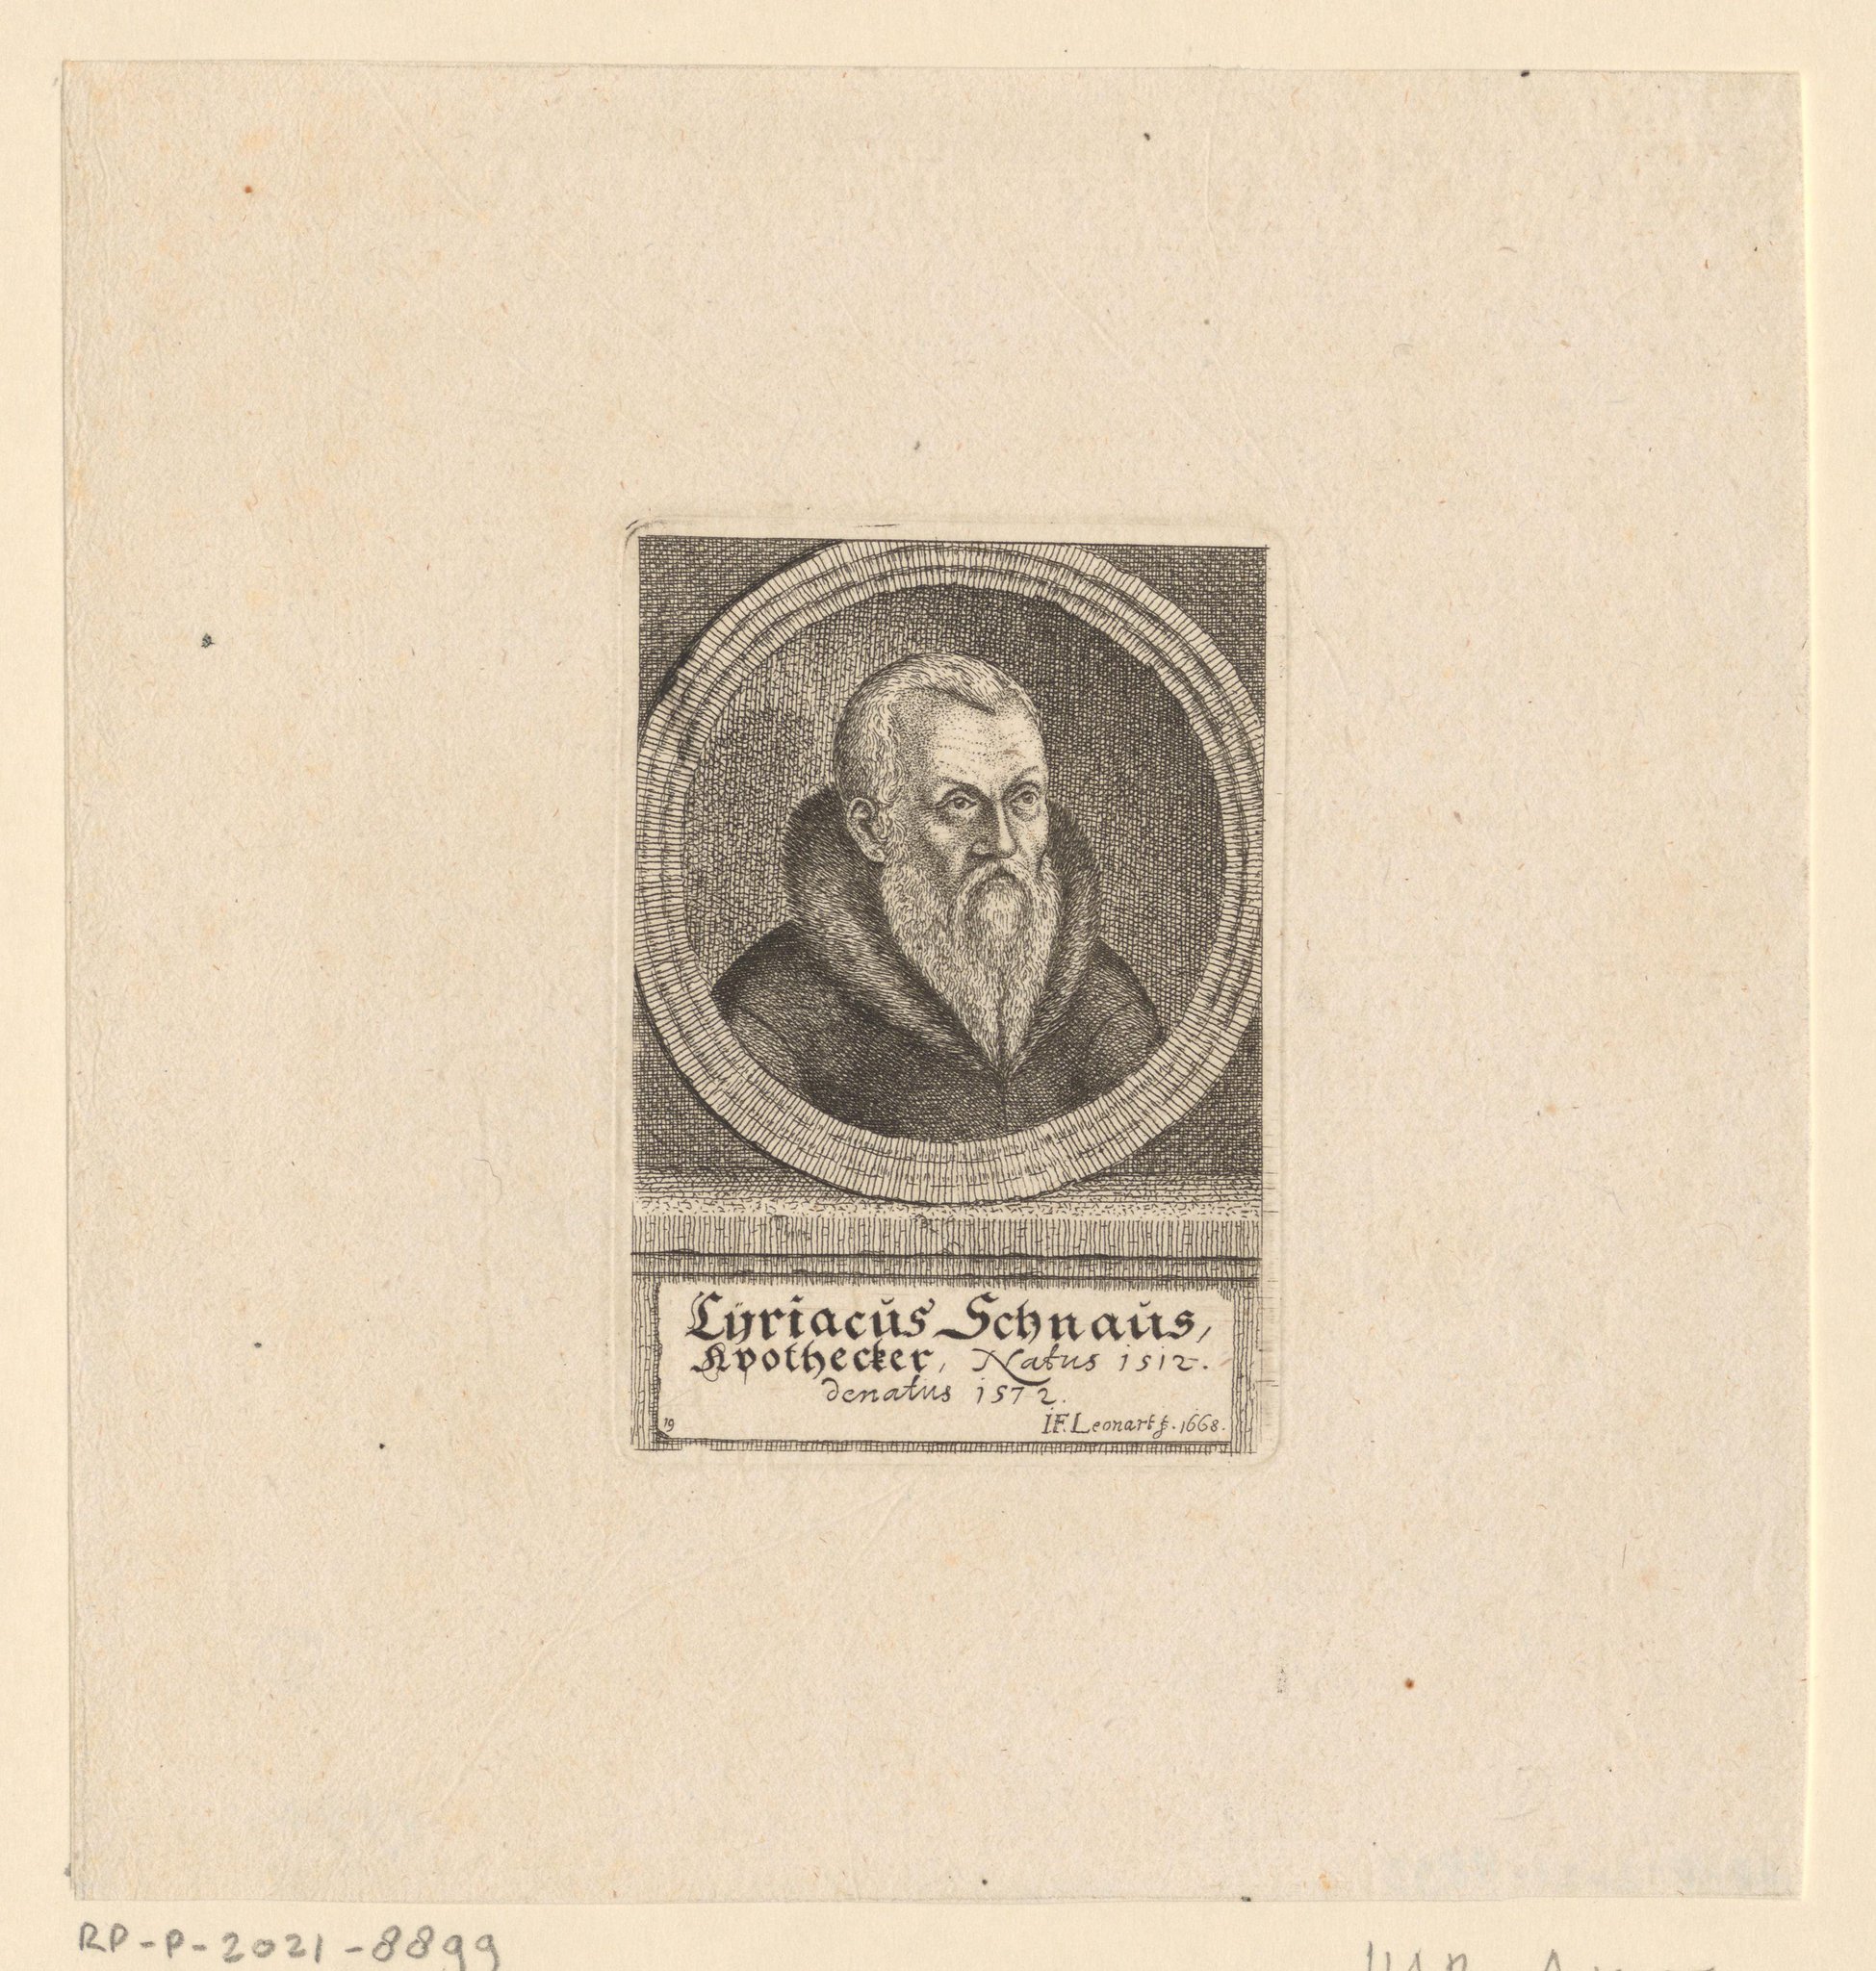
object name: print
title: Portret van Cyriac Schnaus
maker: johann friedrich leonard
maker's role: print maker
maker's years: 1633-1680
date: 1668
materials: paper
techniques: etching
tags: pharmacist, druggist, apothecary; pharmacy, drugstore, dispensing chemist, historical persons